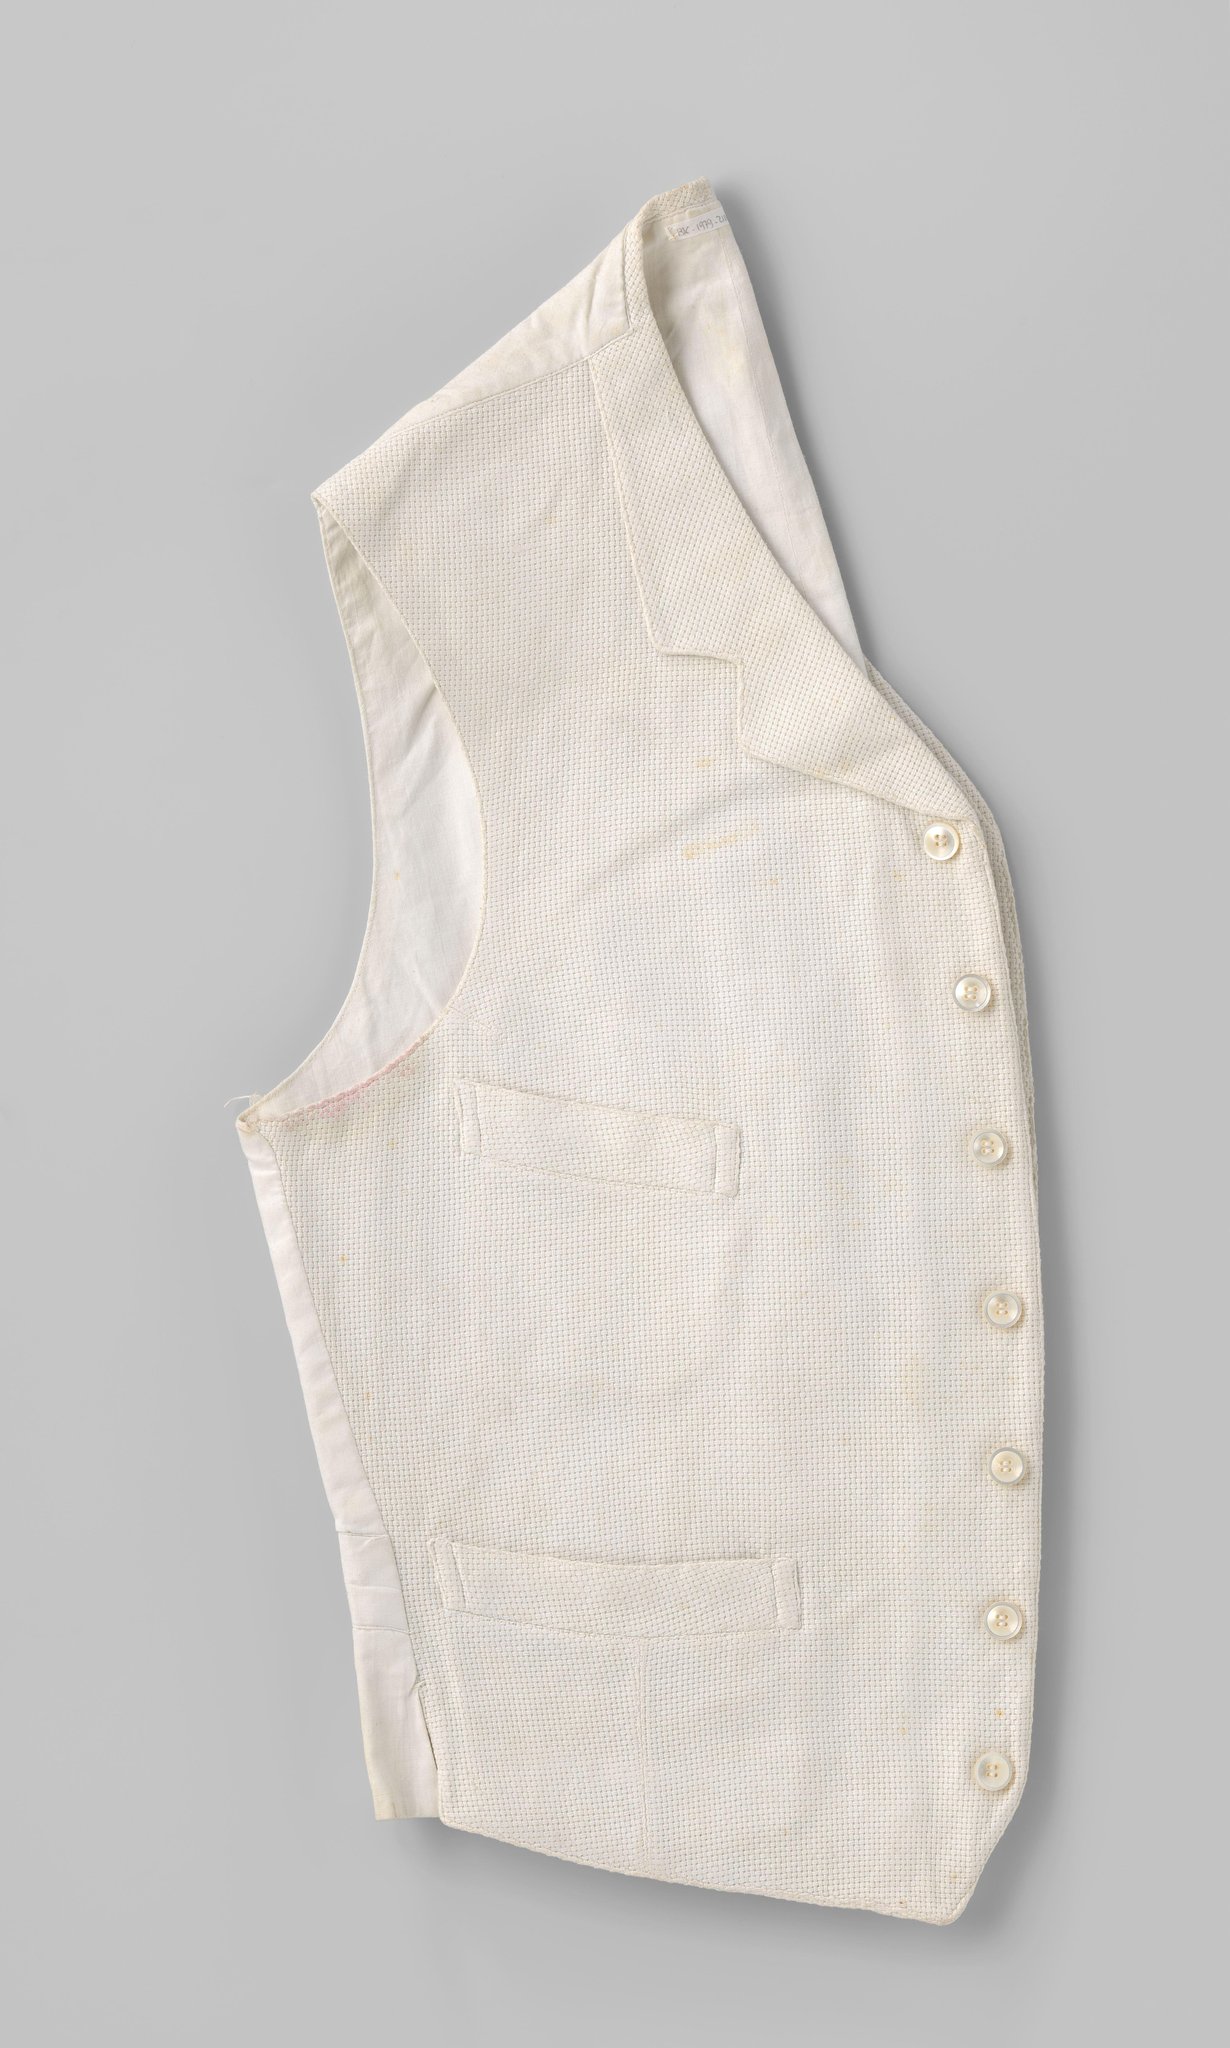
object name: menswear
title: Vest met reverskraag, vier steekzakken en zeven parelmoeren knopen van wit gesteven katoen met open platbinding met dubbele draad; rug van wit katoen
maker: Anonymous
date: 1920-1945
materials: cotton, mother of pearl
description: Het nummer BK-1979-210 stond op een briefje aangegeven, gerelateerd aan drie herenvesten (nu dus a,b en c genummerd) alsmede de herkomst van Gevers van Marquette. Mogelijk een livreivest.